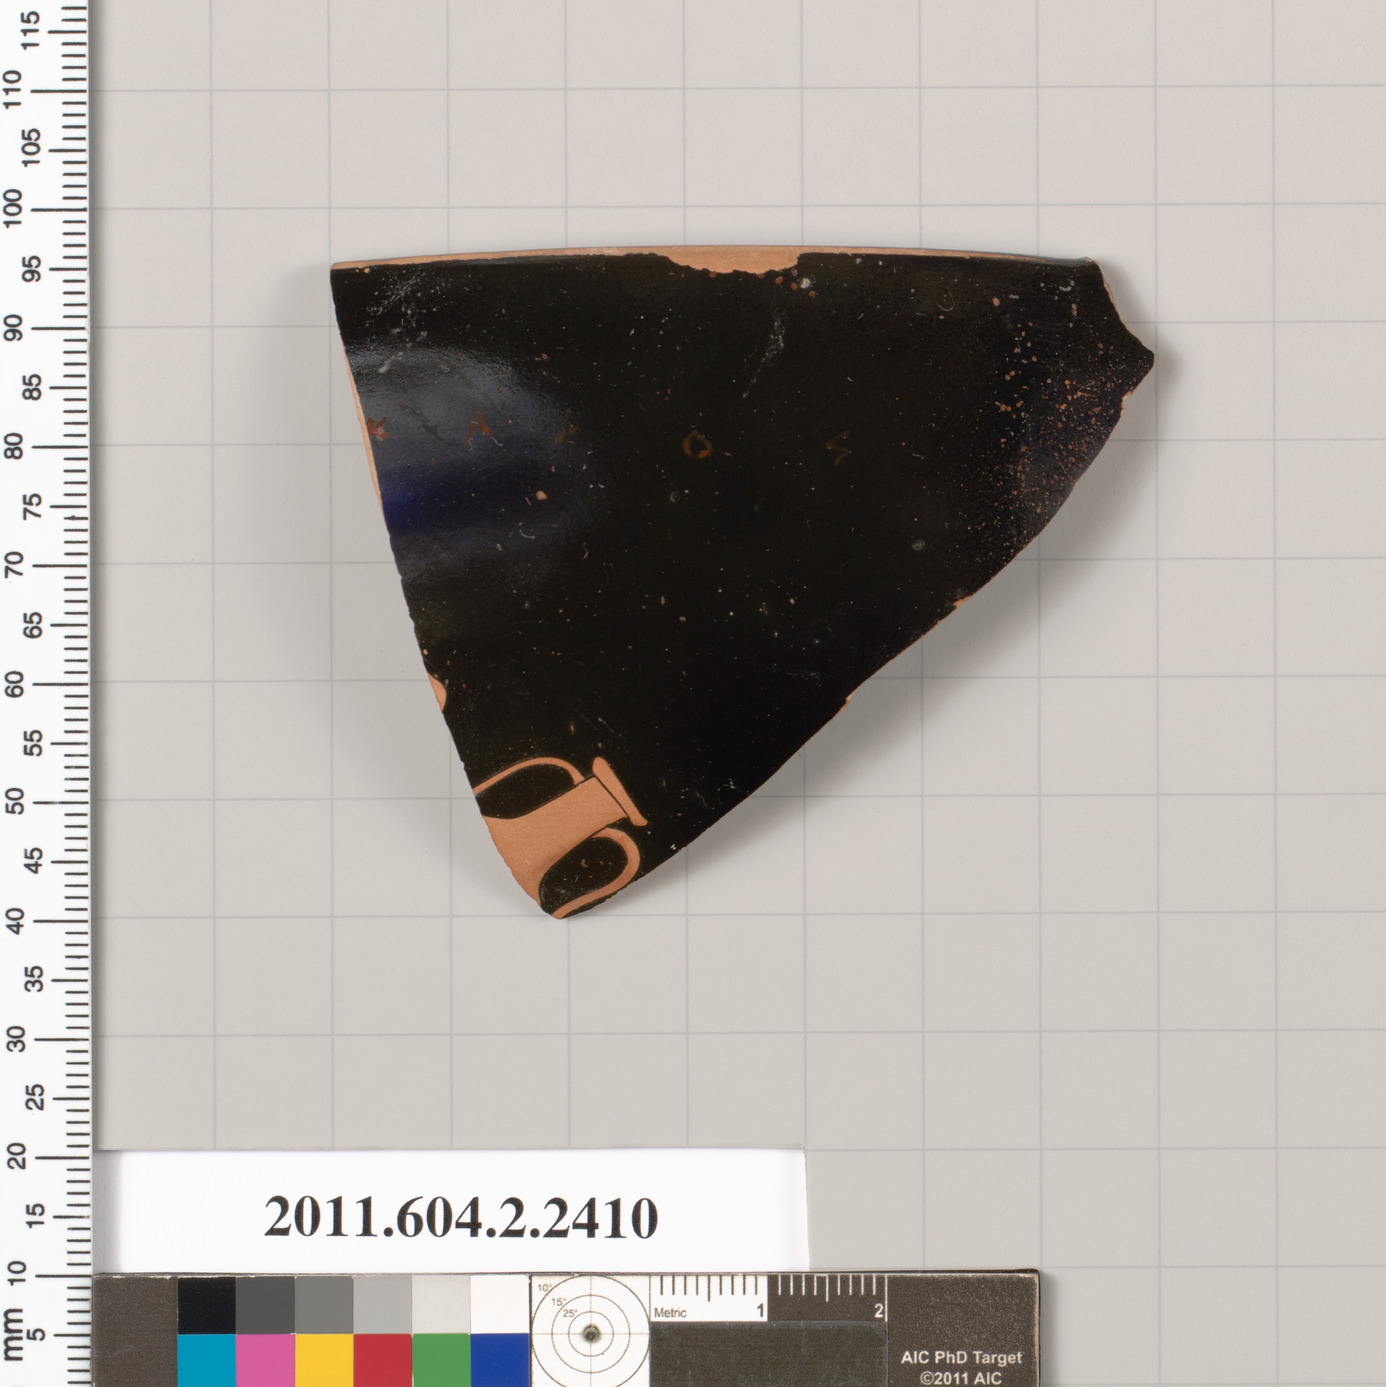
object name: skyphos fragment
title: Terracotta rim fragment of a skyphos (deep drinking cup)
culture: greek, attic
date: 470 BCE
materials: terracotta